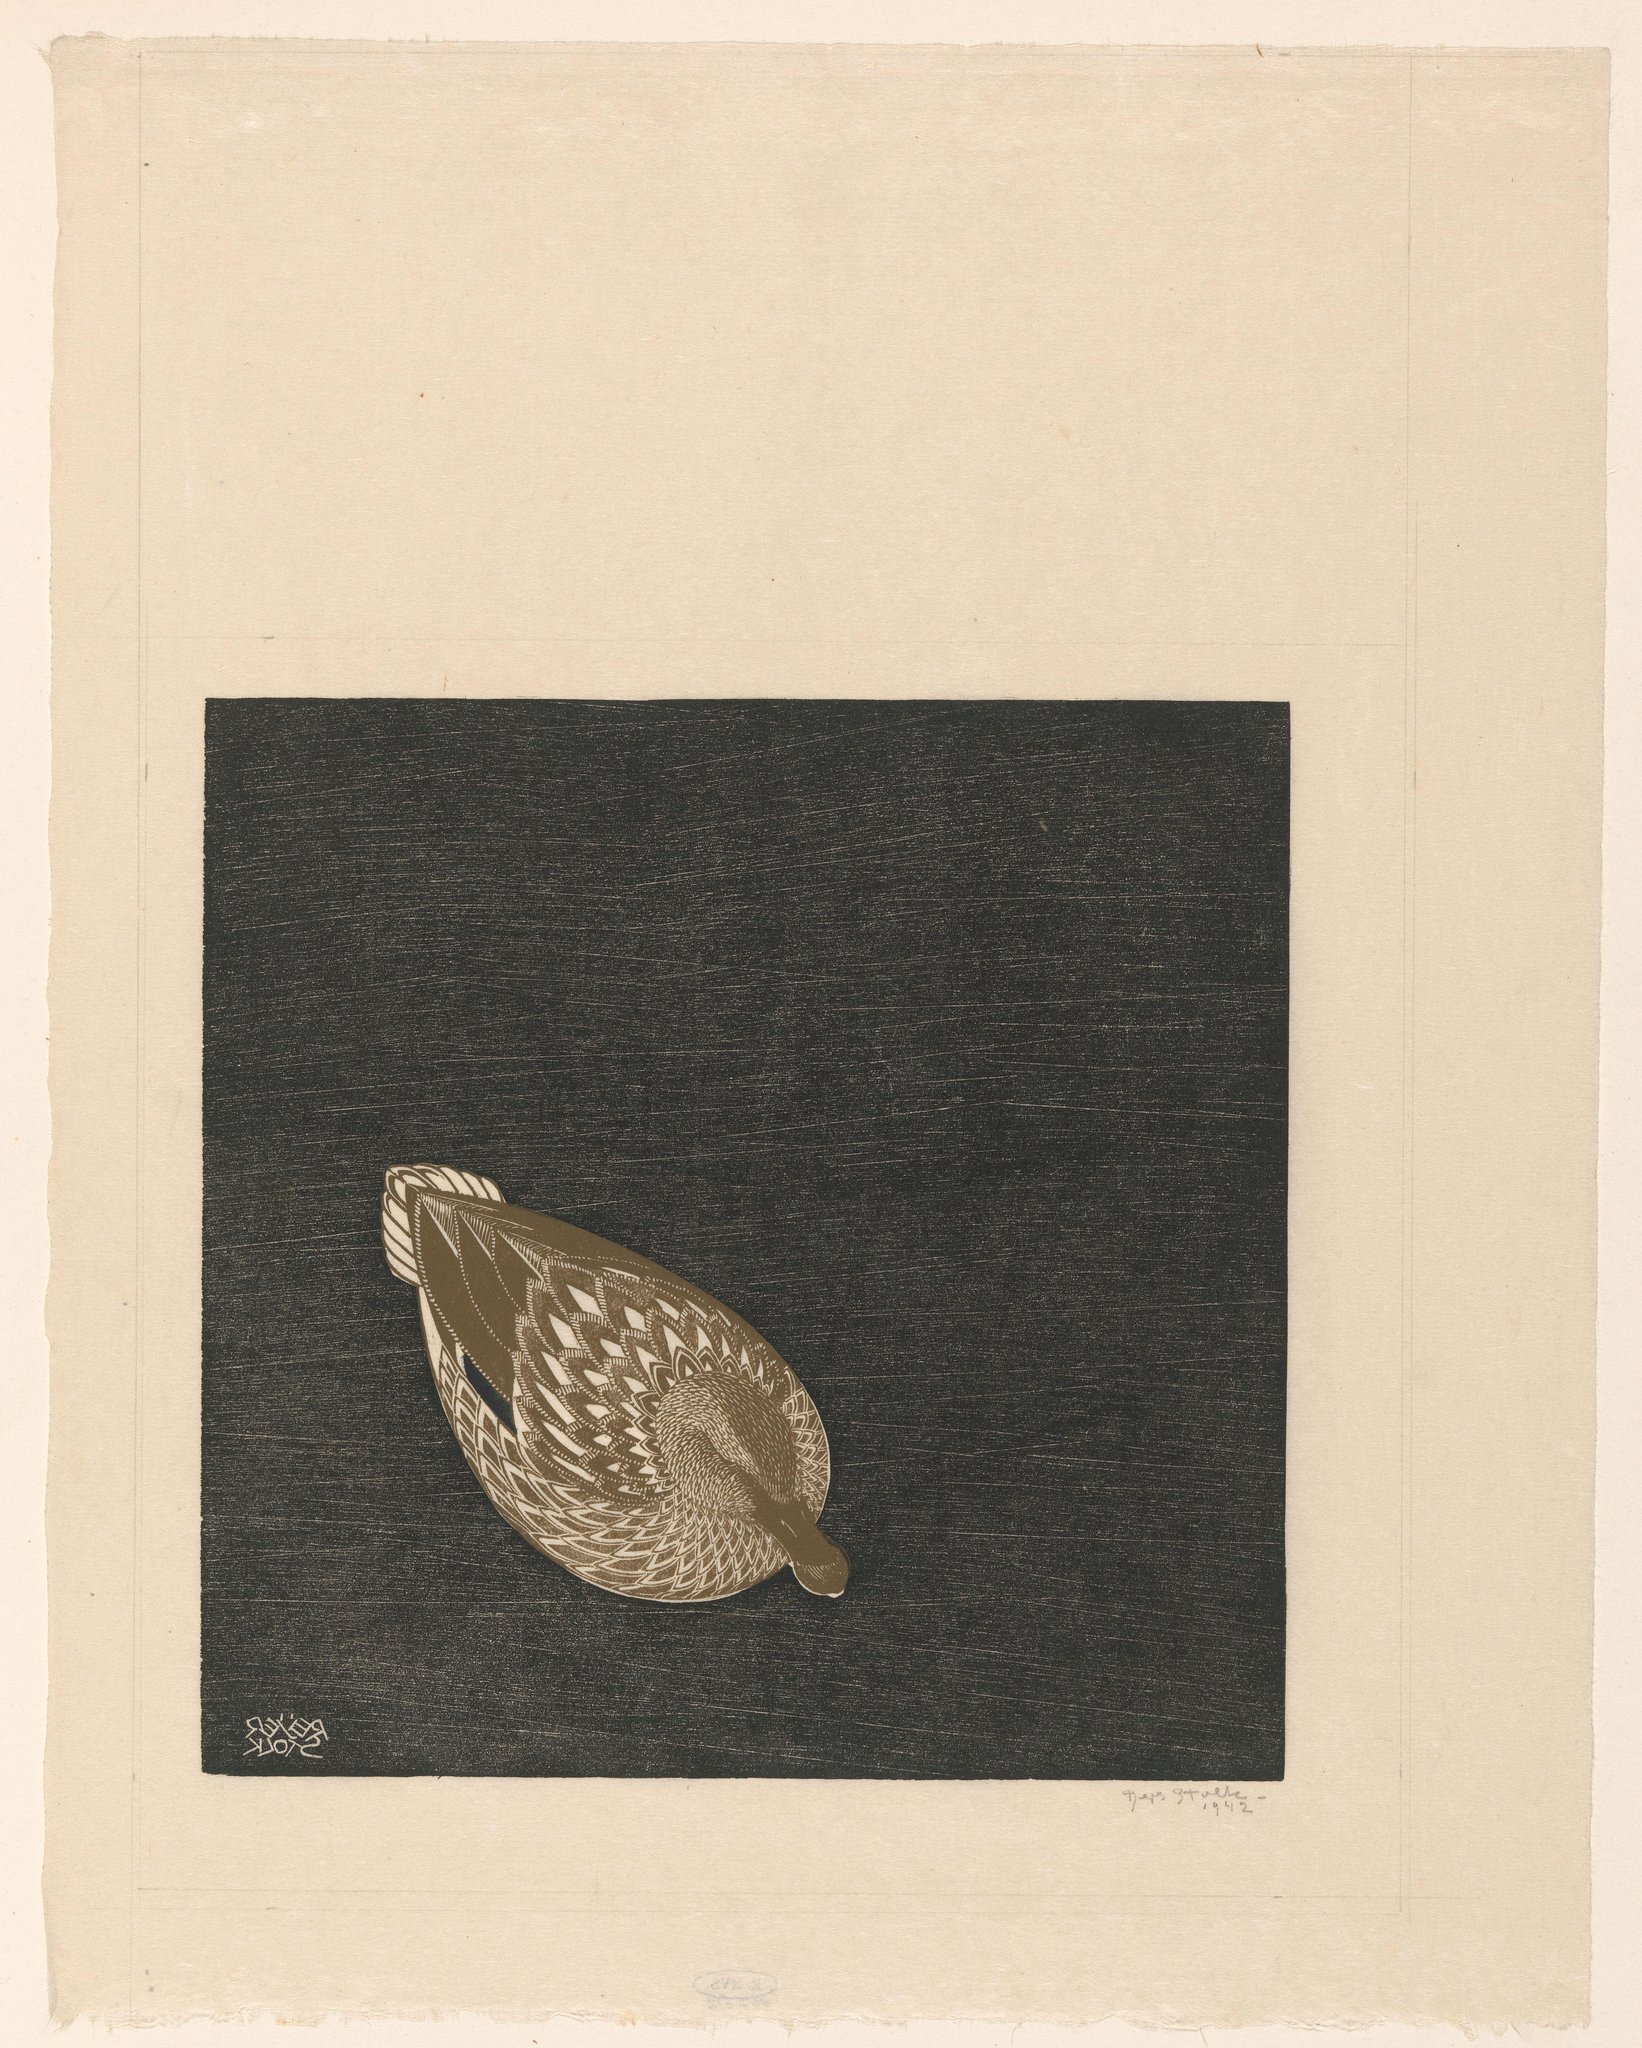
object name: print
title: Eend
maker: reijer stolk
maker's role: draughtsman, print maker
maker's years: 1896-1945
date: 1942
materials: paper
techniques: woodcut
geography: netherlands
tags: water-birds: duck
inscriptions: collector's mark: Lugt 2228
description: Prent gebruikt voor: H.A. Gerretsen, 'Reijer Stolk, werk en persoonlijkheid', Maandblad voor beeldende kunsten 25 (1949), p. 48.